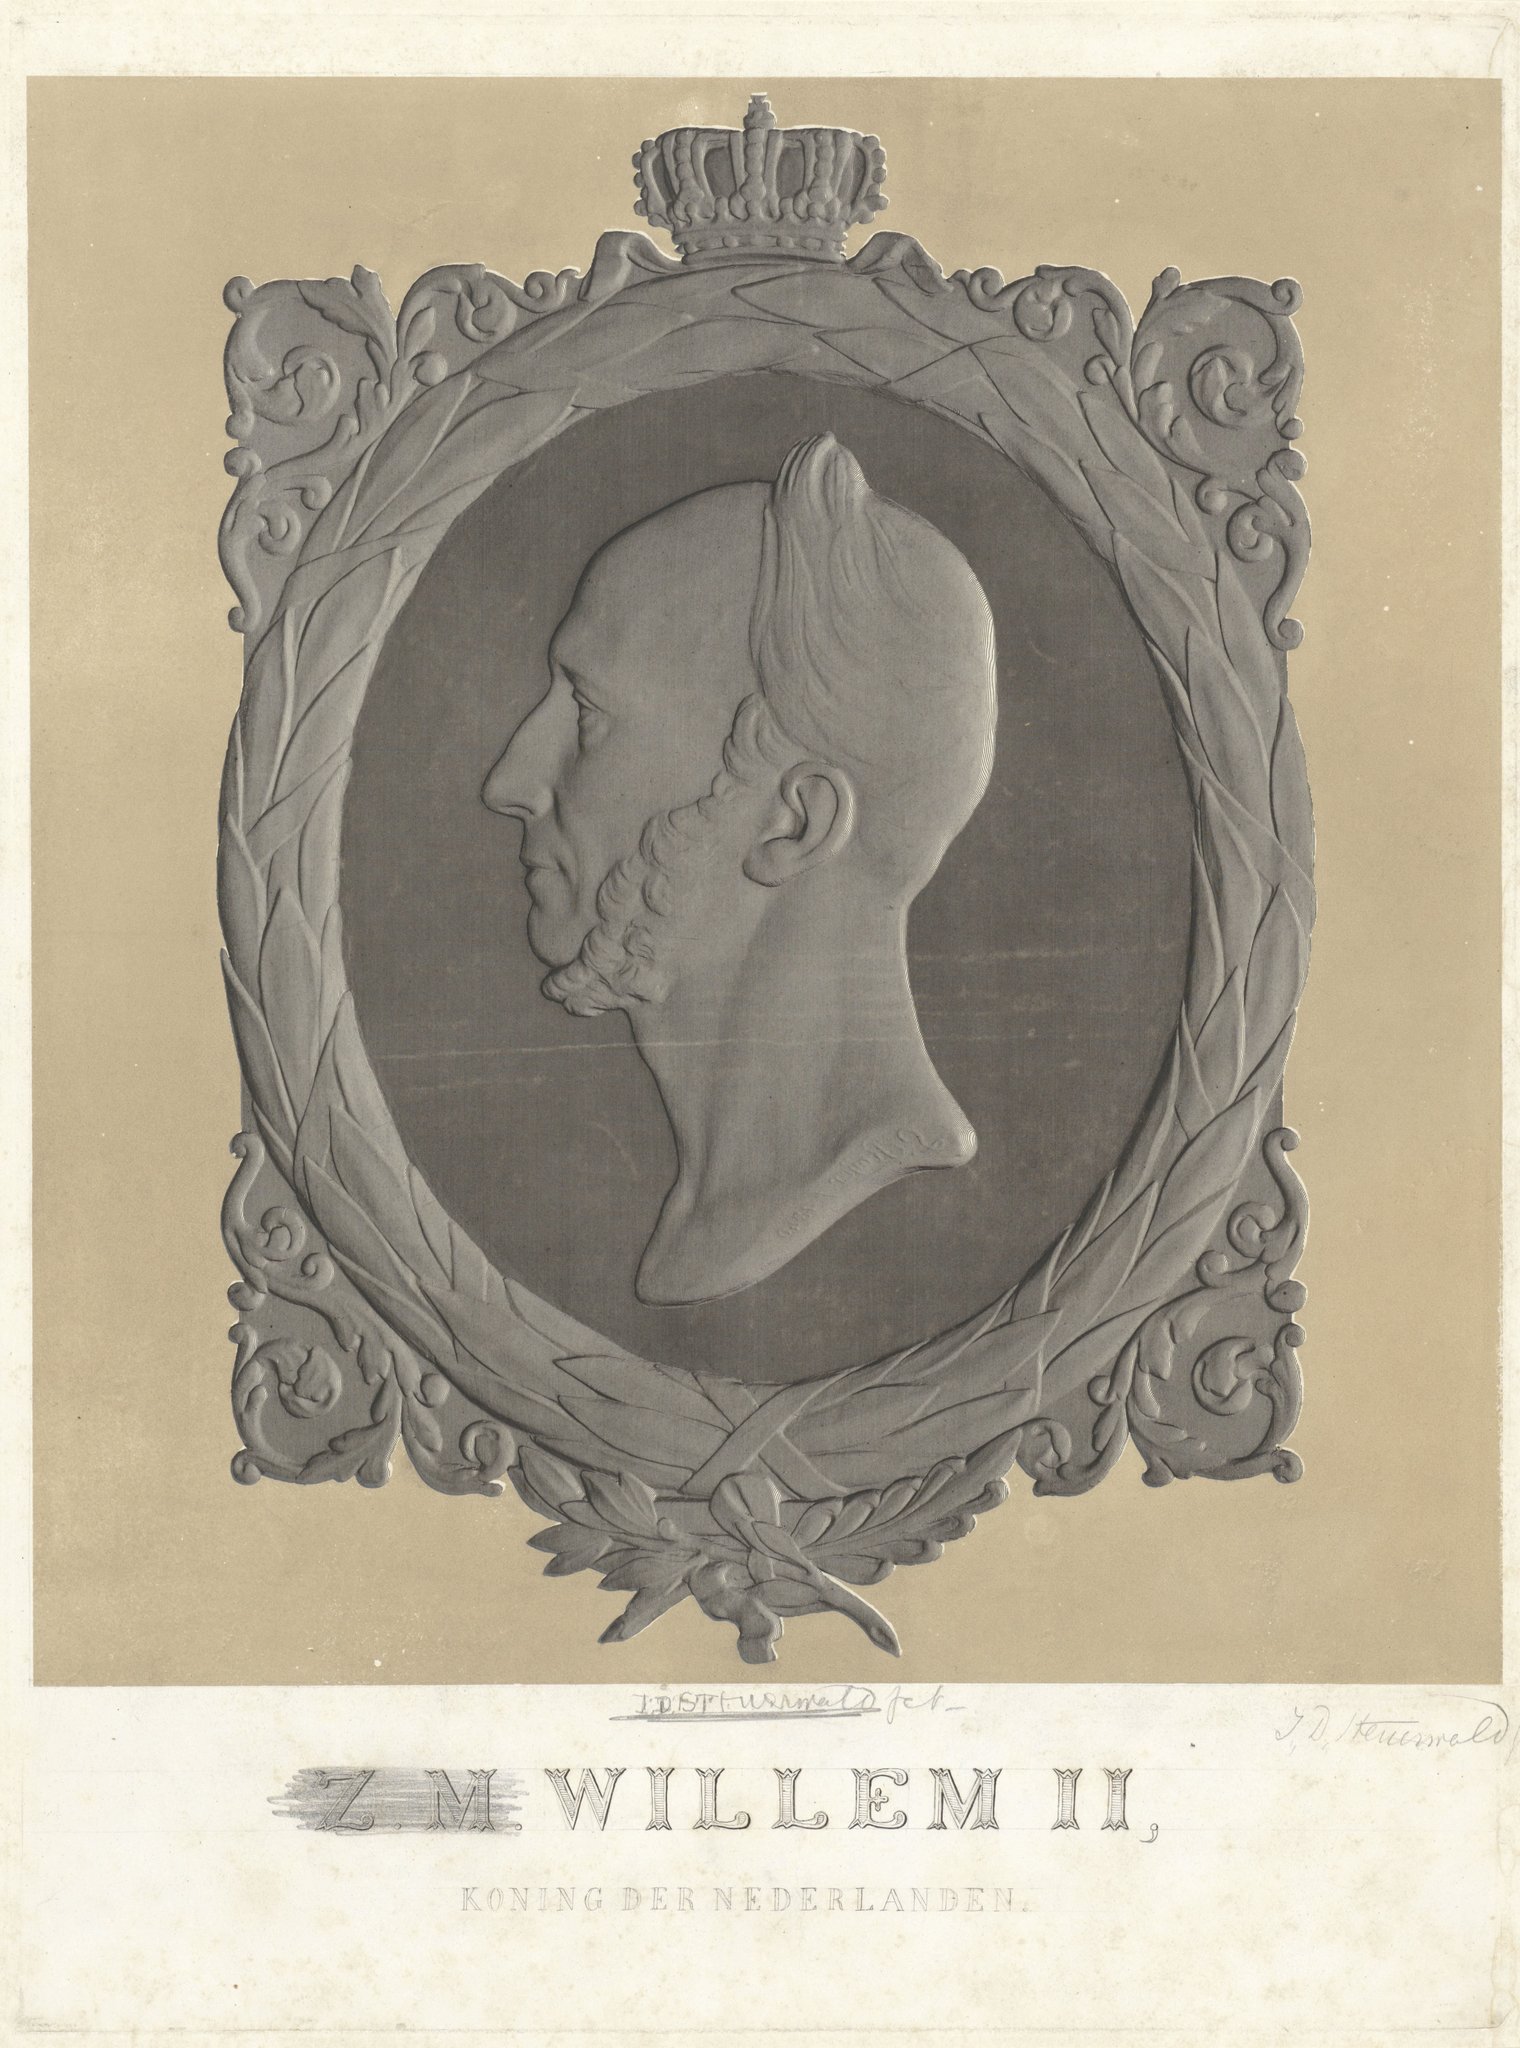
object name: print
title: Portret van Willem II, koning der Nederlanden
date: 1840-1842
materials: paper, pencil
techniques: etching, engraving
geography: the hague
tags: william ii of the netherlands, king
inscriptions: collector's mark: Lugt 2228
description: Portret van Willem II, koning der Nederlanden, in profiel. Rond de voorstelling een gekroonde omlijsting bestaande uit een lauwerkrans.